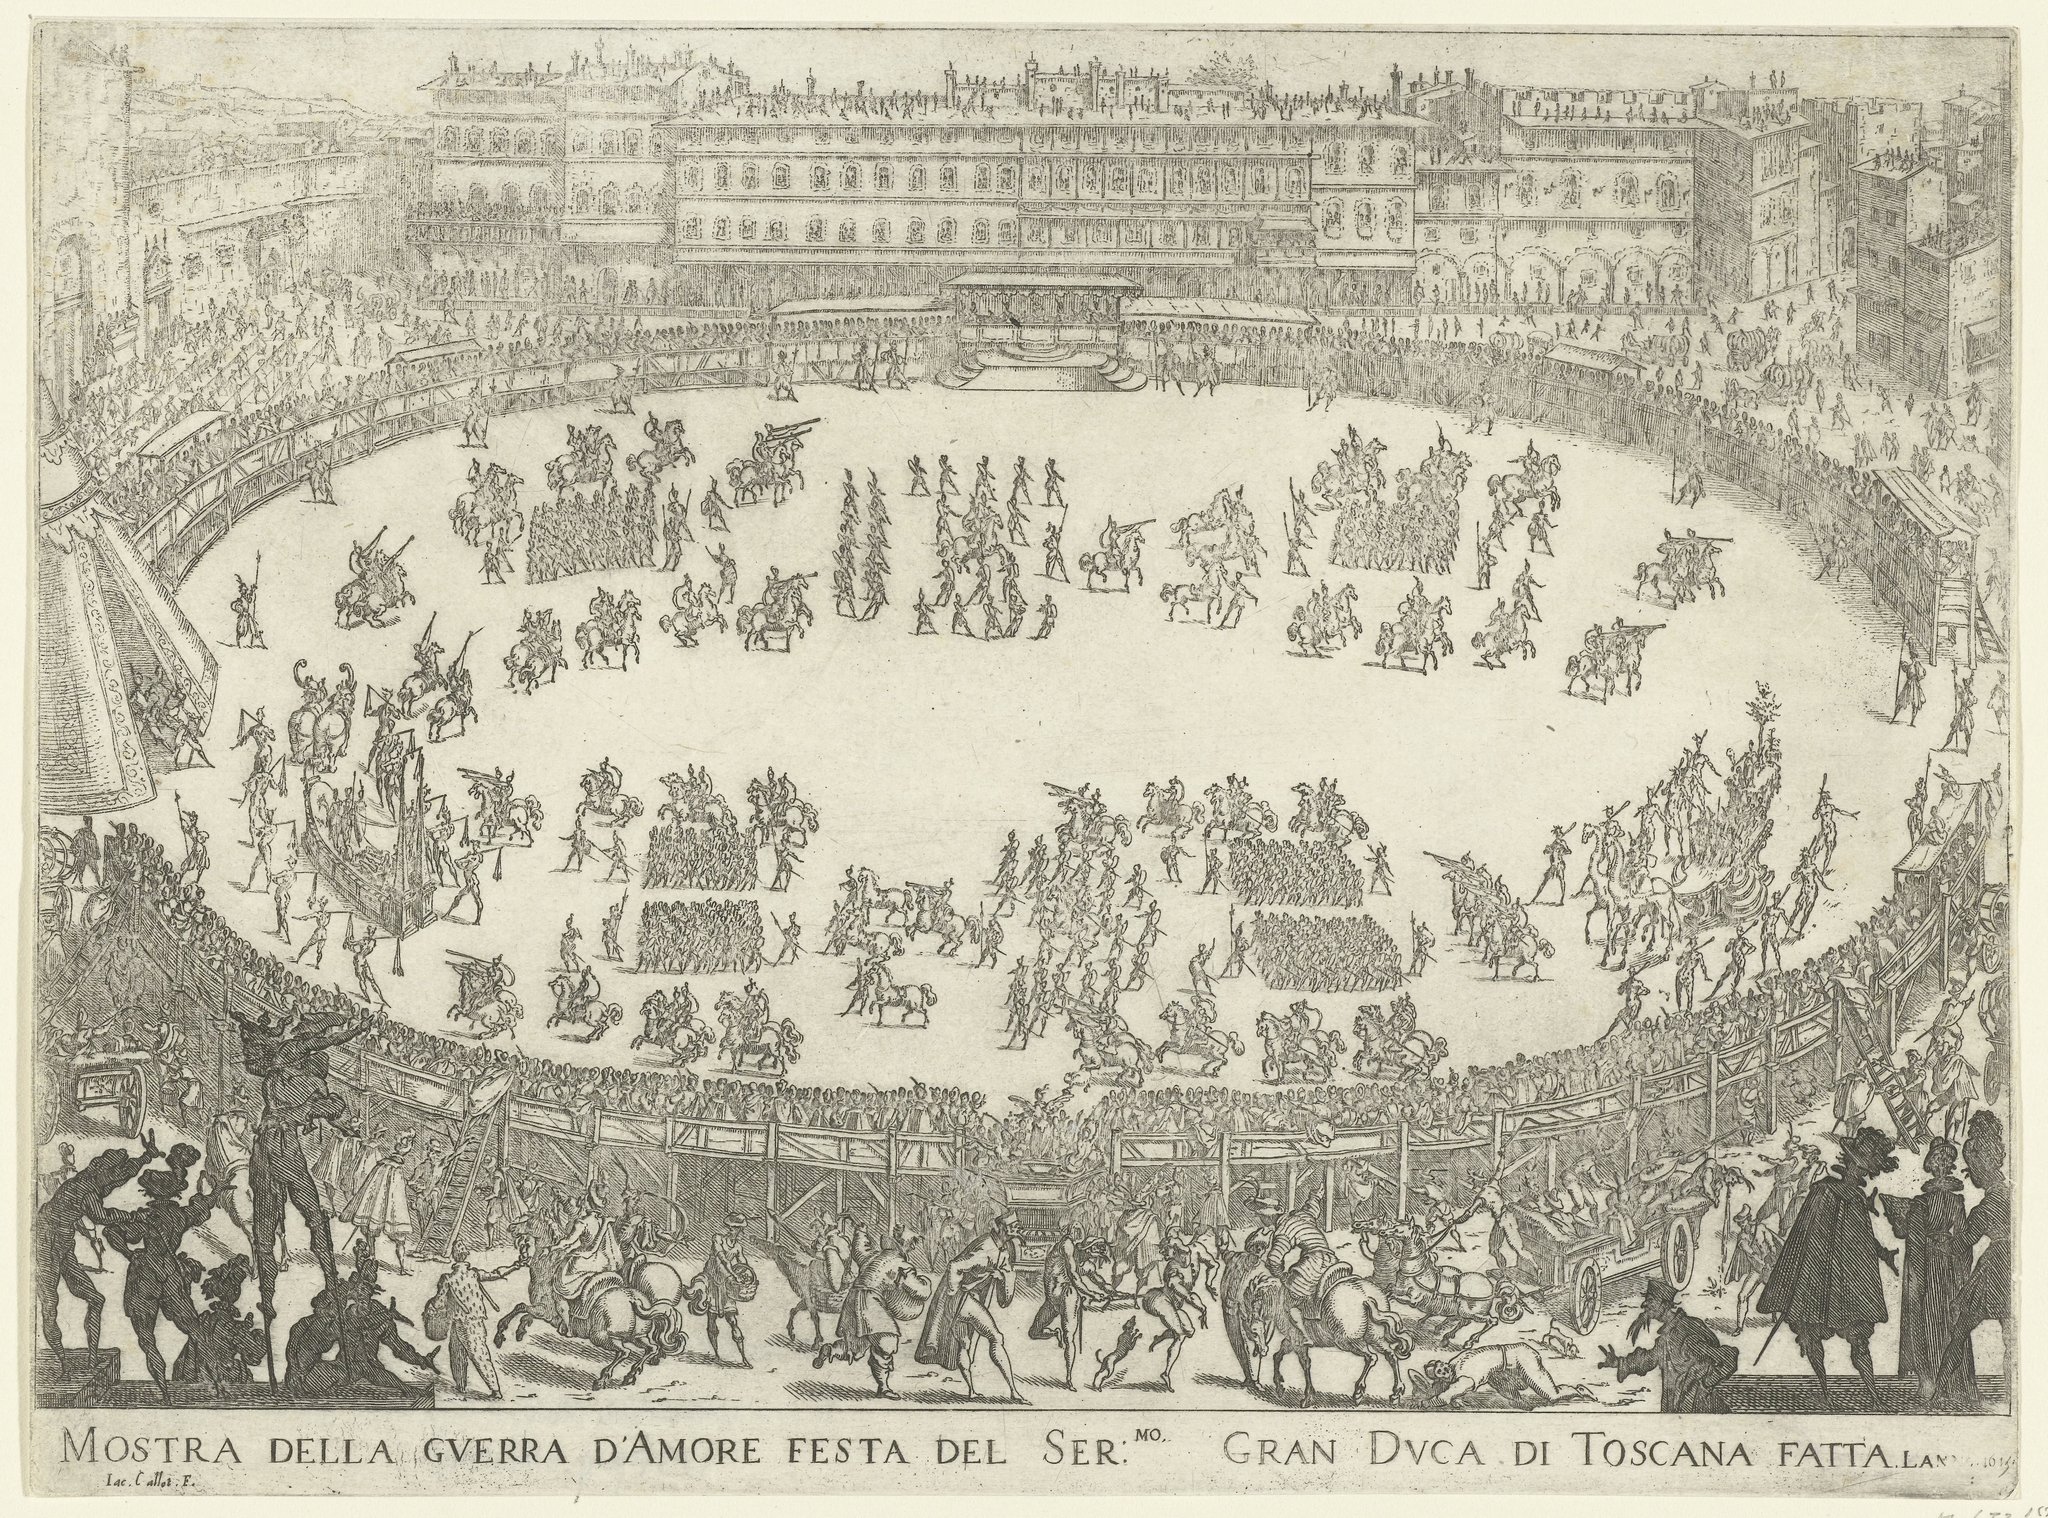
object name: print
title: Carnaval te Florence: optocht van soldaten en praalwagens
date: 1616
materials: paper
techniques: etching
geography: florence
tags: cosimo ii de' medici, chariot, triumphal car, carnival, shrovetide (non-liturgical celebration), village square, place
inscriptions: collector's mark: Lugt 240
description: Gezicht op de Piazza Santa Croce in Florence, waar twee praalwagens en vele soldaten te voet en te paard paraderen voor toeschouwers, die op in ovaalvorm geplaatst tribunes zitten. Deze optocht vond plaats tijdens het carnavalsfeest 'Guerra d'Amore', dat Cosimo II de' Medici in 1616 in Florence gaf. Onder de voorstelling een regel Italiaanse tekst.